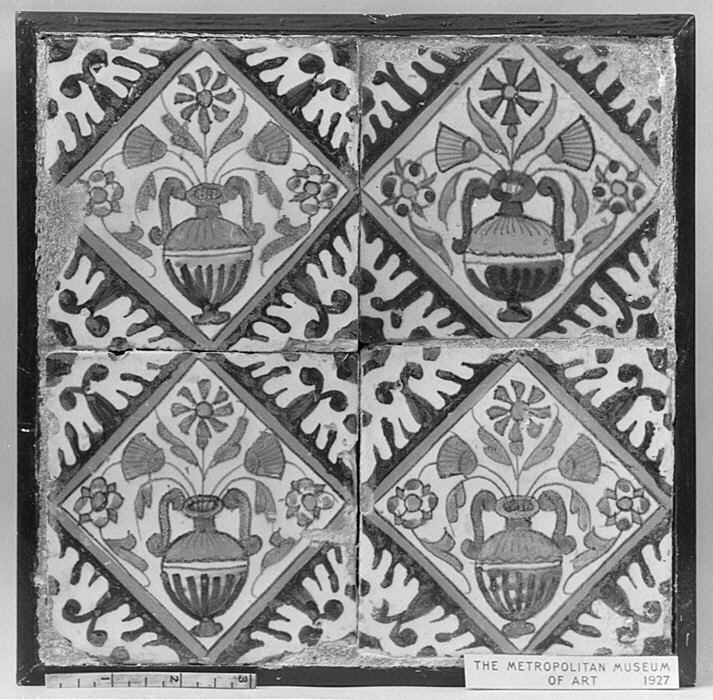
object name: tile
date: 1580-1625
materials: earthenware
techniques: glazing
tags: flowers